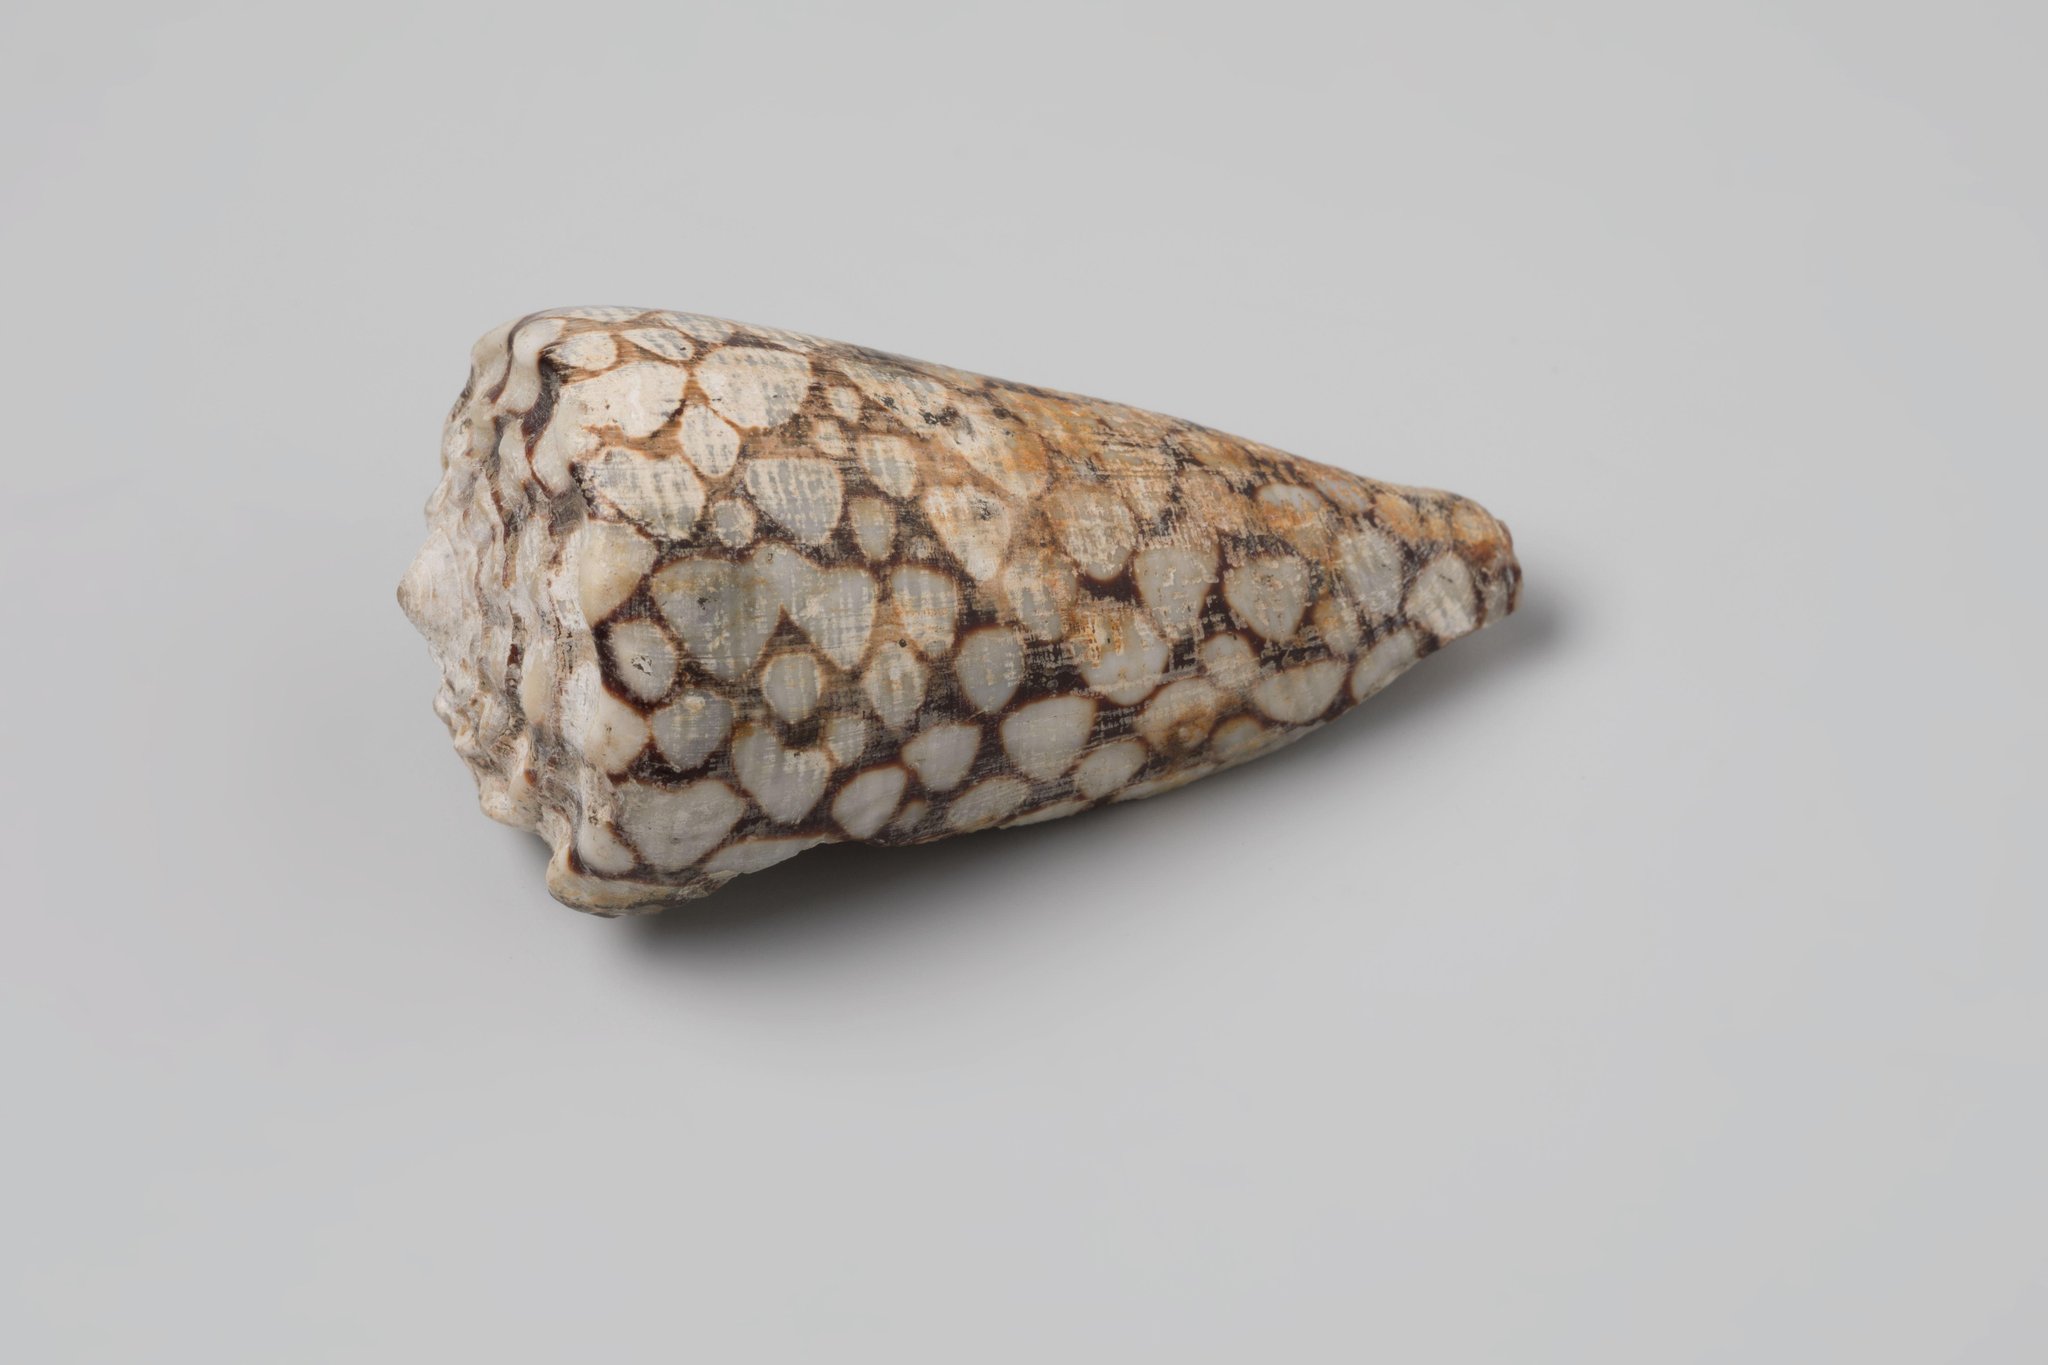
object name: conus marmoreus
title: Conus marmoreus shell from the wreck of the Dutch East India ship Witte Leeuw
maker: niet van toepassing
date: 1613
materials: shell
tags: verenigde oostindische compagnie, sint-helena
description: Schelp uit V.O.C.-schip de 'Witte Leeuw'.